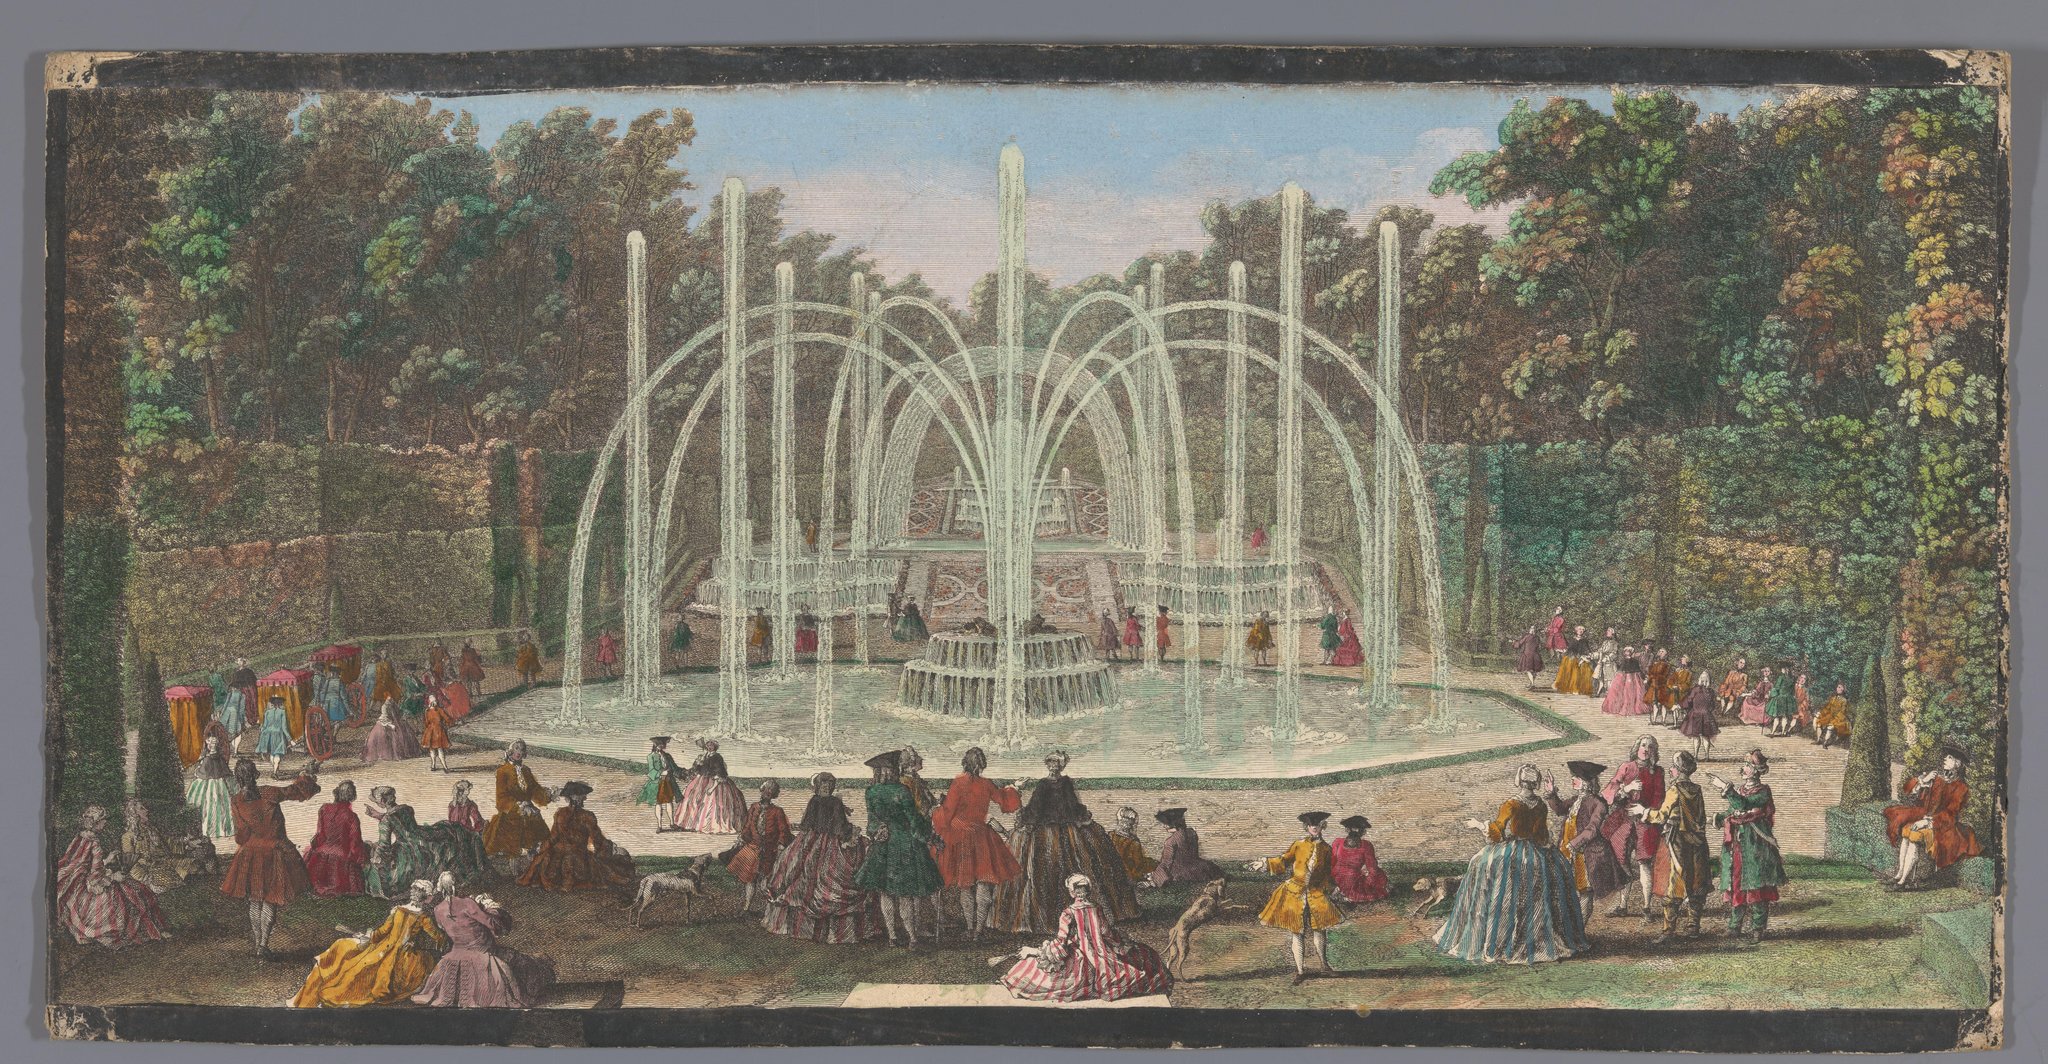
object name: opticaprent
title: Gezicht op het Bosquet des Trois Fontaines in de Tuin van Versailles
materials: cardboard, paper, watercolor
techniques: brush, etching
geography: paris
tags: garden, garden fountain, ornamental plants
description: In de ondermarge vier regels Franse tekst.